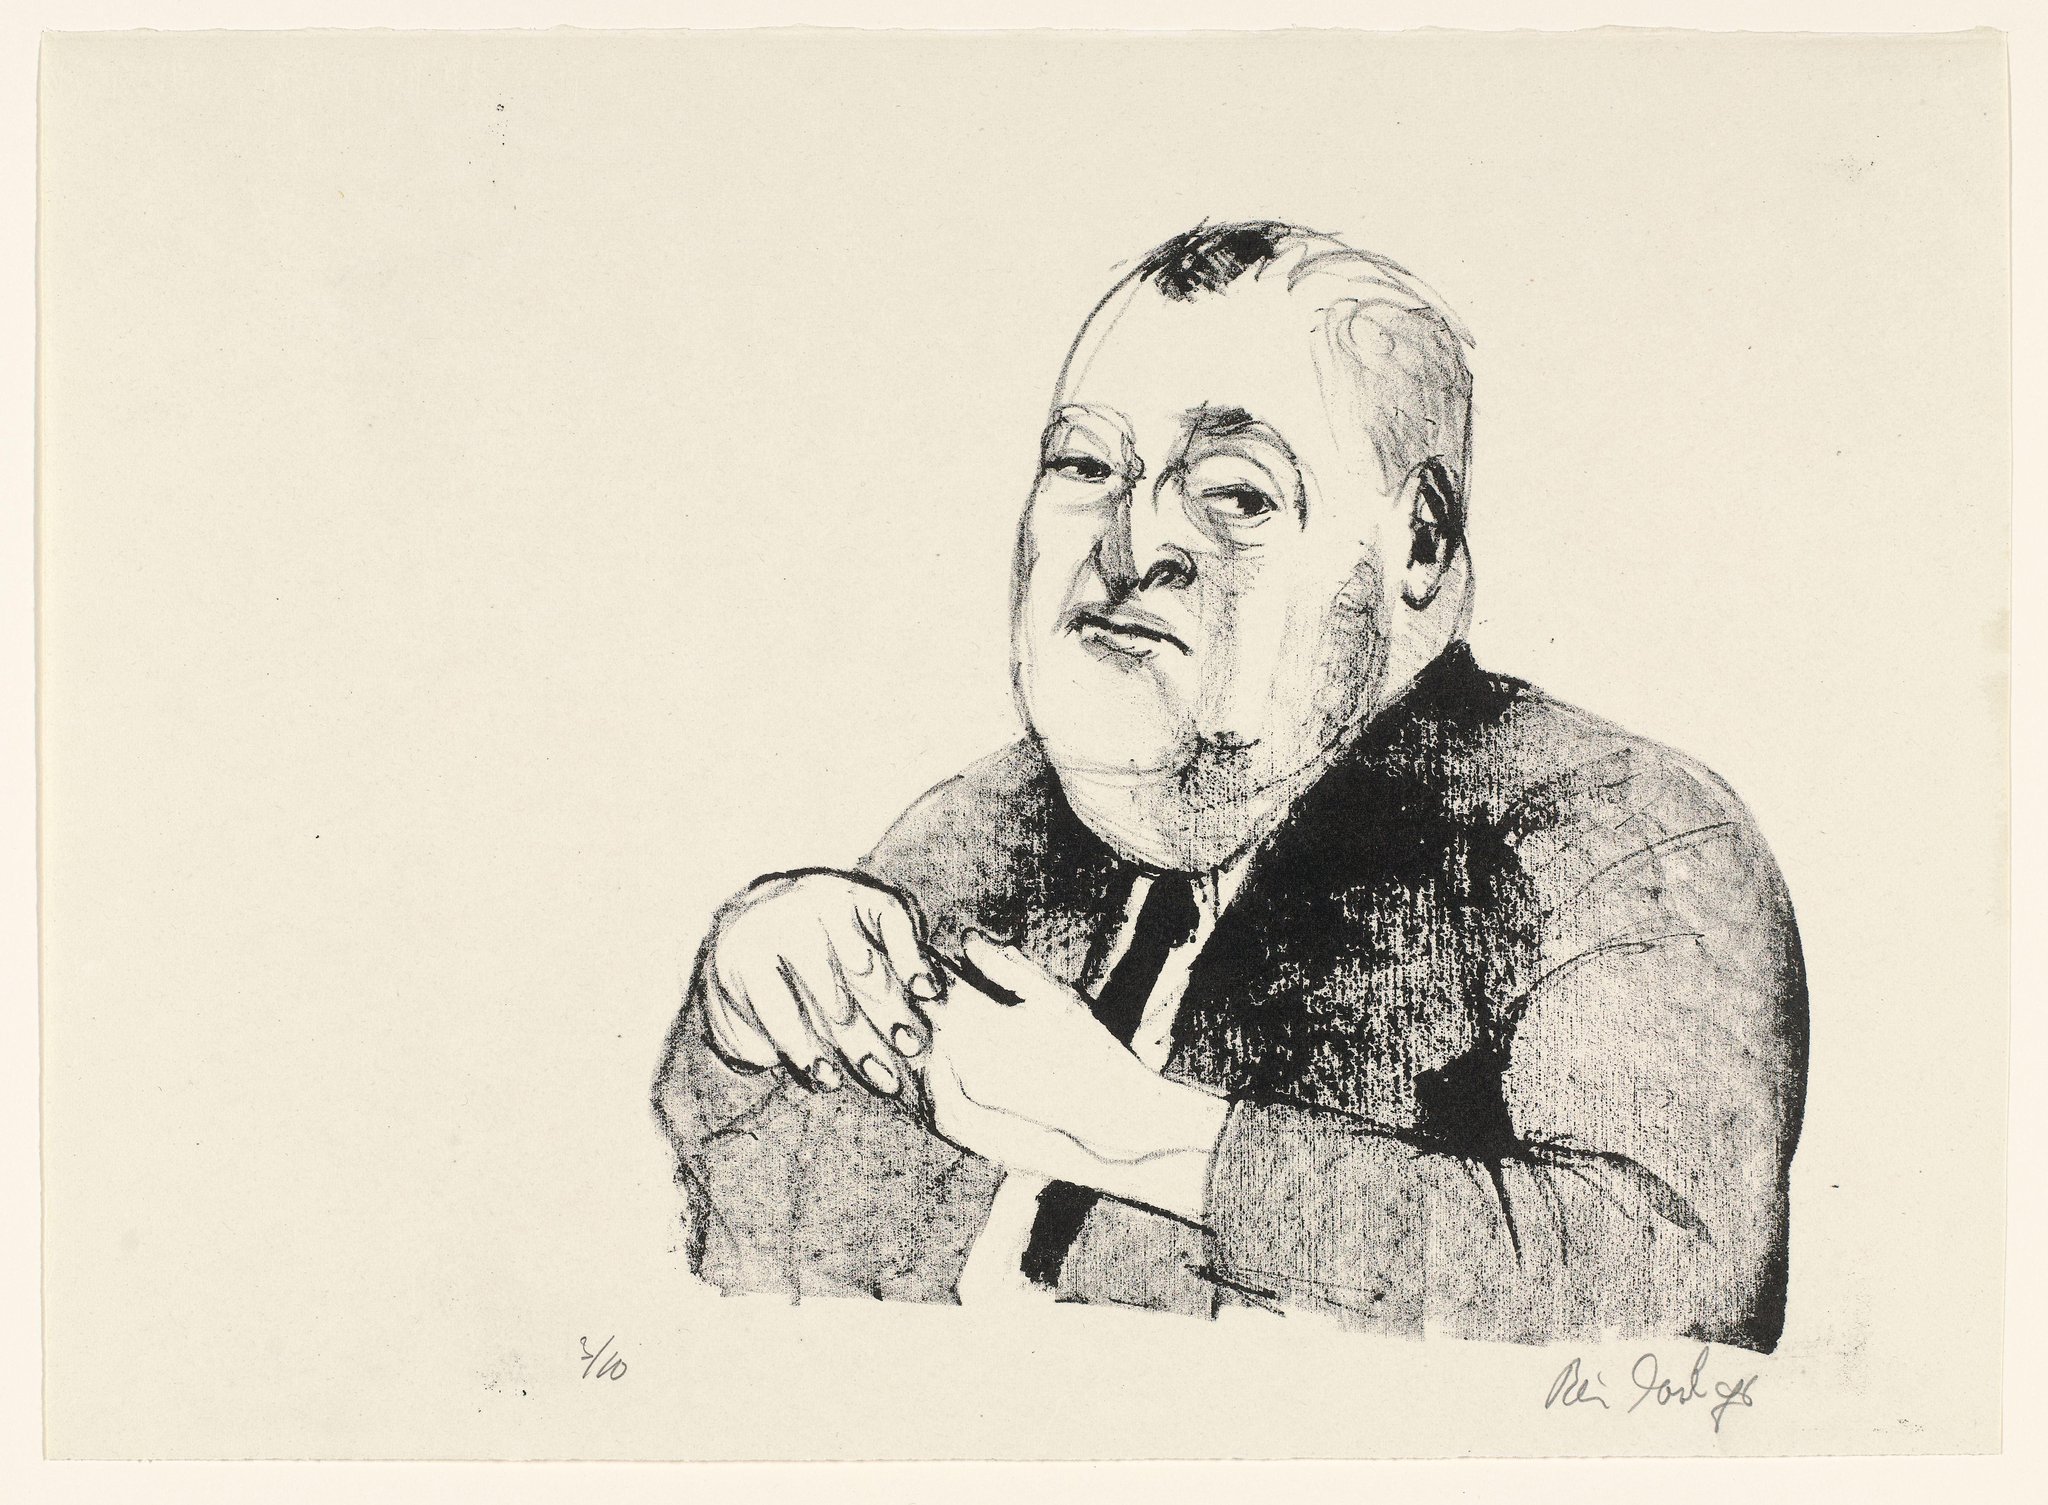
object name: print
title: Bestuurscollege Rijksuniversiteit Leiden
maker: rein dool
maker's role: draughtsman, painter, print maker, sculptor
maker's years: 1933-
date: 1976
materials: paper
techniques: lithograph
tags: universiteit van leiden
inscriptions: edition: ‘3/10’, signature and date: ‘Rein Dool 76’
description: De serietitel is door het museum toegekend bij gebrek aan informatie over een originele serietitel.